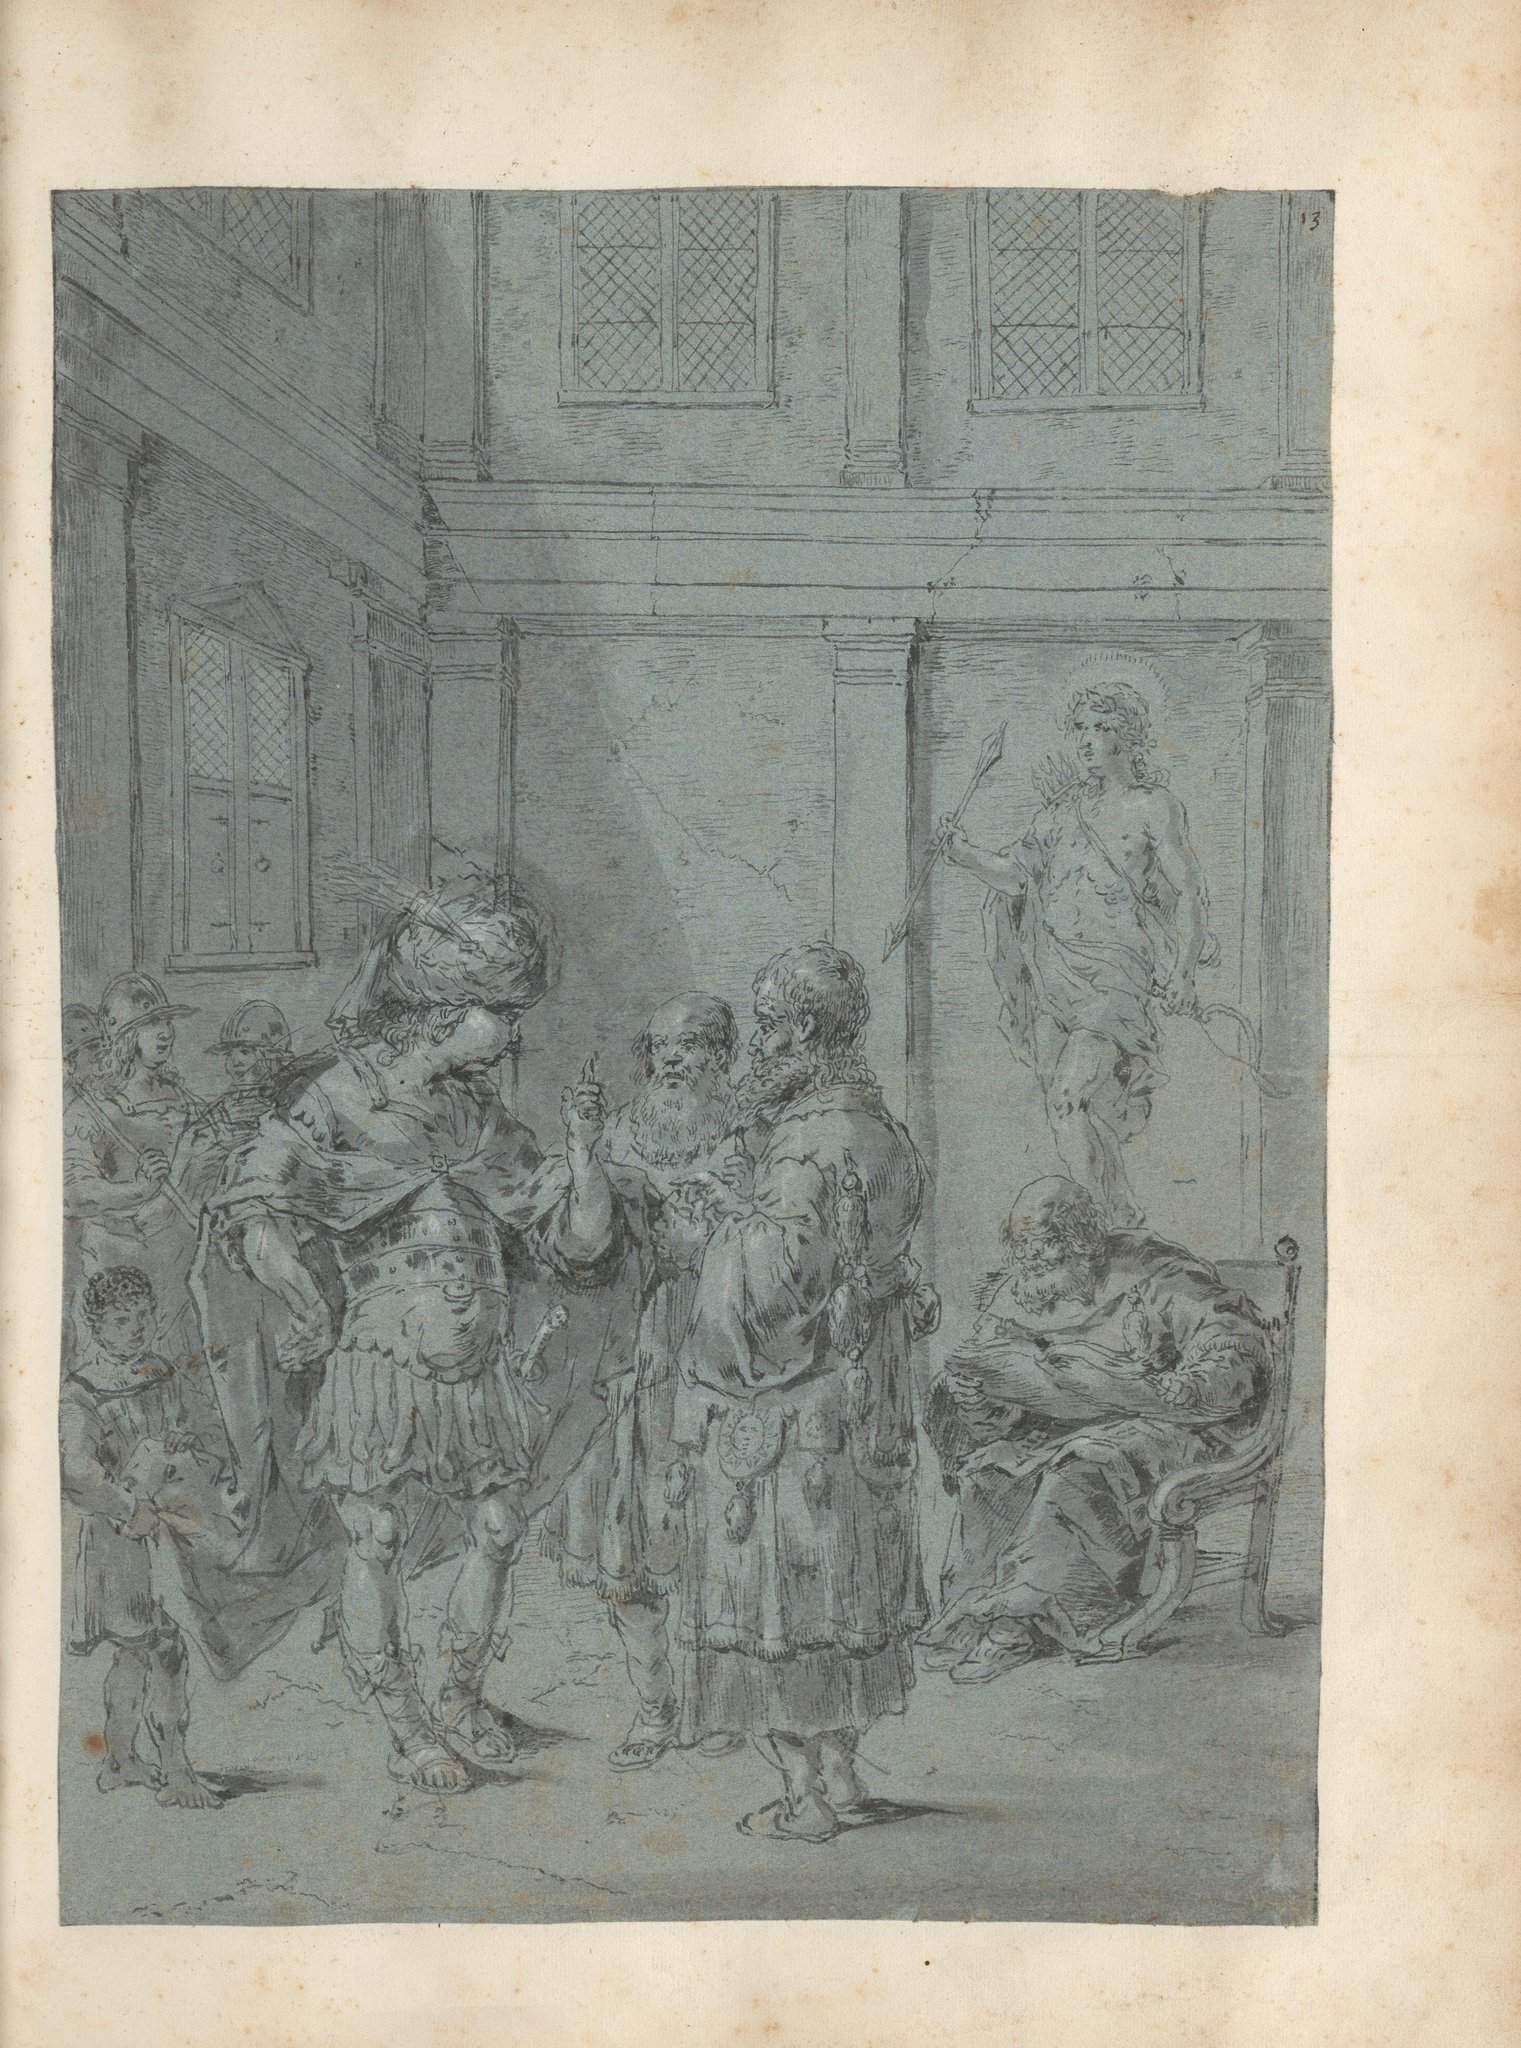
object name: album leaf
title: Alexander de Grote bij het Orakel van Delphi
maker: leonaert bramer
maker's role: draughtsman, painter, print maker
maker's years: 1596-1674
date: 1655-1665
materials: paint, ink, paper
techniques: brush, pen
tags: (story of) apollo (phoebus), alexander drags the priestess of delphi to the temple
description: Alexander de Grote bezoekt het Orakel van Delphi om een voorspelling te krijgen over de uitkomst van zijn oorlog tegen de Perzen. Hij krijgt te horen dat er op die dag geen voorspellingen gedaan mogen worden. In plaats van de Pythia, de hogepriesteres van het orakel, staat Alexander hier met een dreigend handgebaar tegenover een paar oudere mannen. Met op de achtergrond een beeld van Apollo. Rechtsboven genummerd: 13. Tekening maakt deel uit van een album.